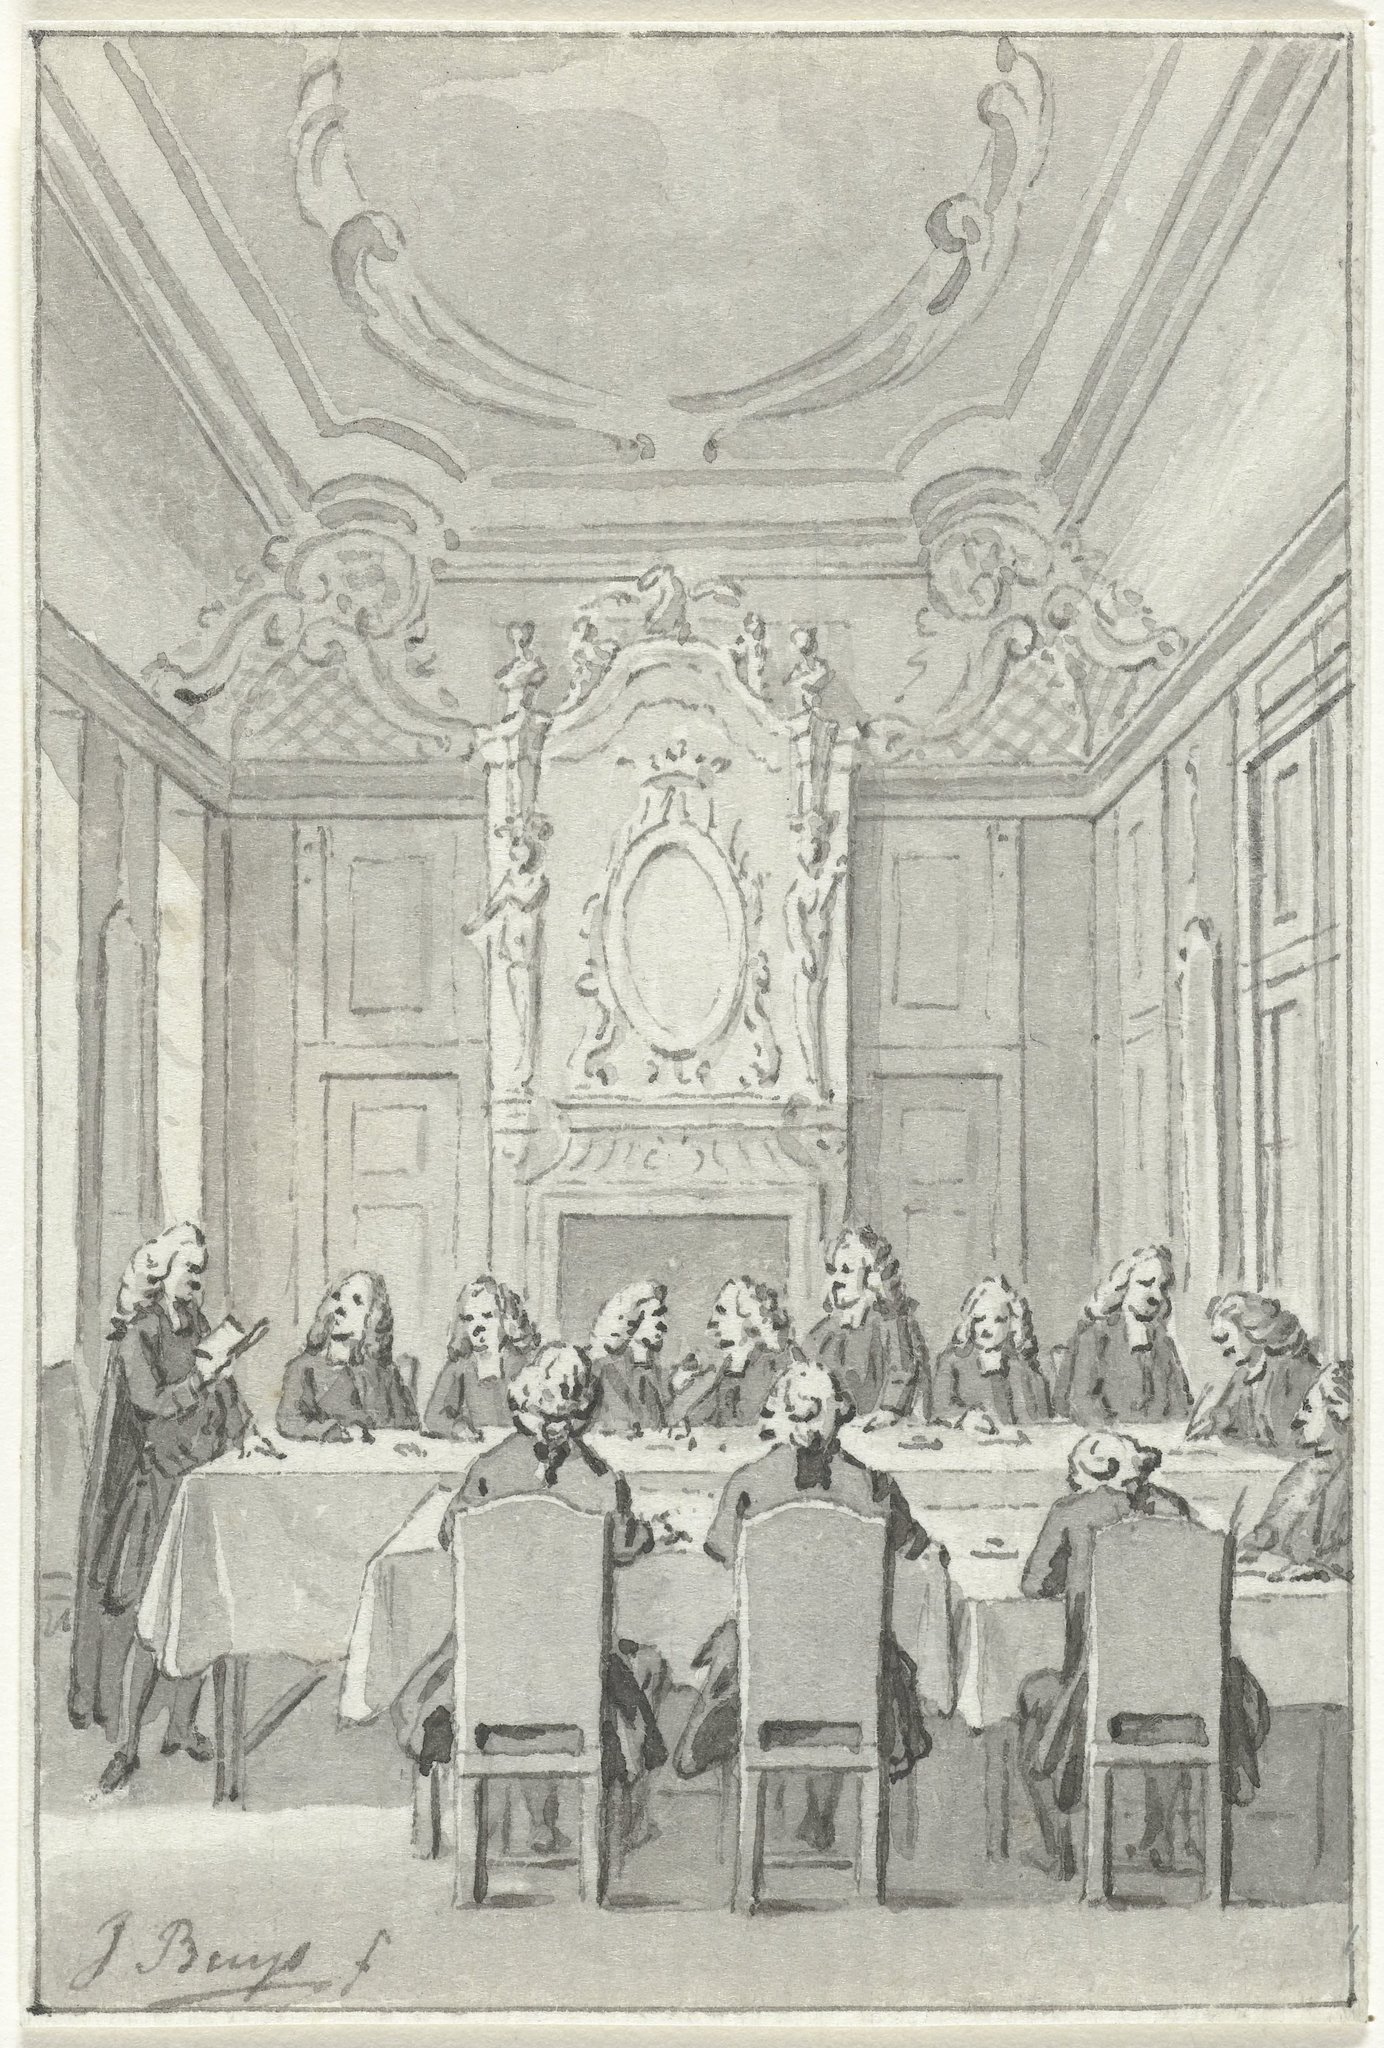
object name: drawing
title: Openbare voorlezing van psalmen in de vergaderzaal van de Gemachtigden in het Mauritshuis, 1 oktober 1777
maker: jacobus buys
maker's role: draughtsman, print maker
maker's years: 1724-1801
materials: ink, paper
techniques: brush, pen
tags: singing of psalms, hymns, etc., meeting, historical events and situations, the hague